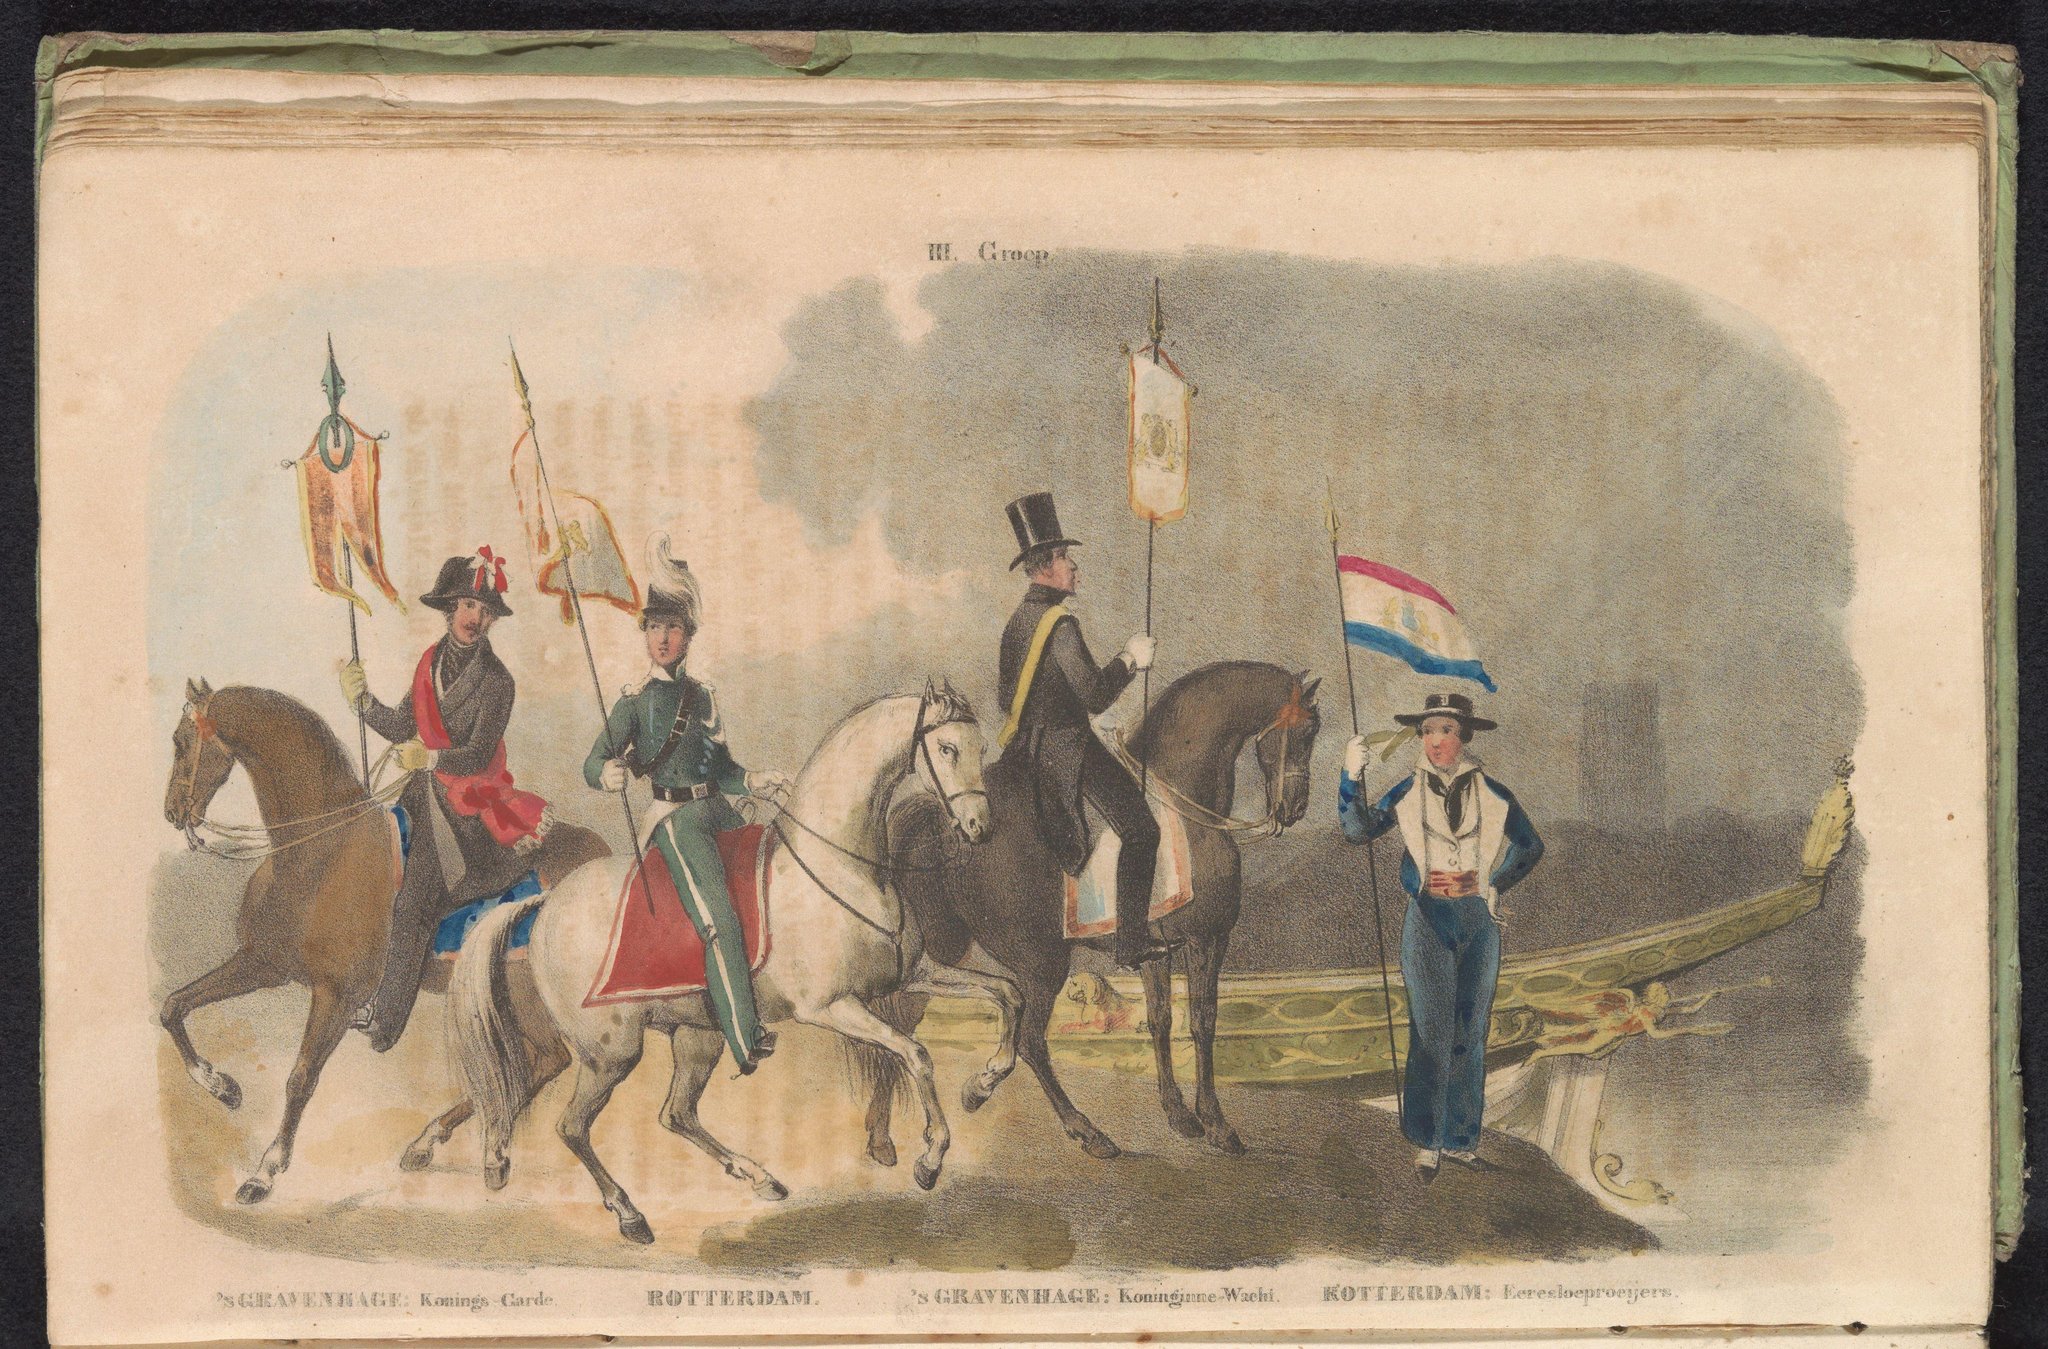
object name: book illustration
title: Kostumen en vaandels van de erewachten van 's-Gravenhage en Rotterdam, 1840-1842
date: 1840-1842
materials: paper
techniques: hand coloring, lithograph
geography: den bosch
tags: william ii of the netherlands, clothes for official occasions, guard of honour, (military) uniforms, the hague, rotterdam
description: Kostumen en vaandels van de burger erewachten van Den Haag en Rotterdam, 1840-1842. Drie mannen in uniform te paard met vaandels. De eresloeproeier te voet met vaandel voor de eresloep. Illustratie in een boek met negen platen van de kleding gedragen door de burgererewachten tijdens het bezoek van koning Willem II aan die stad na zijn inhuldiging in 1840.